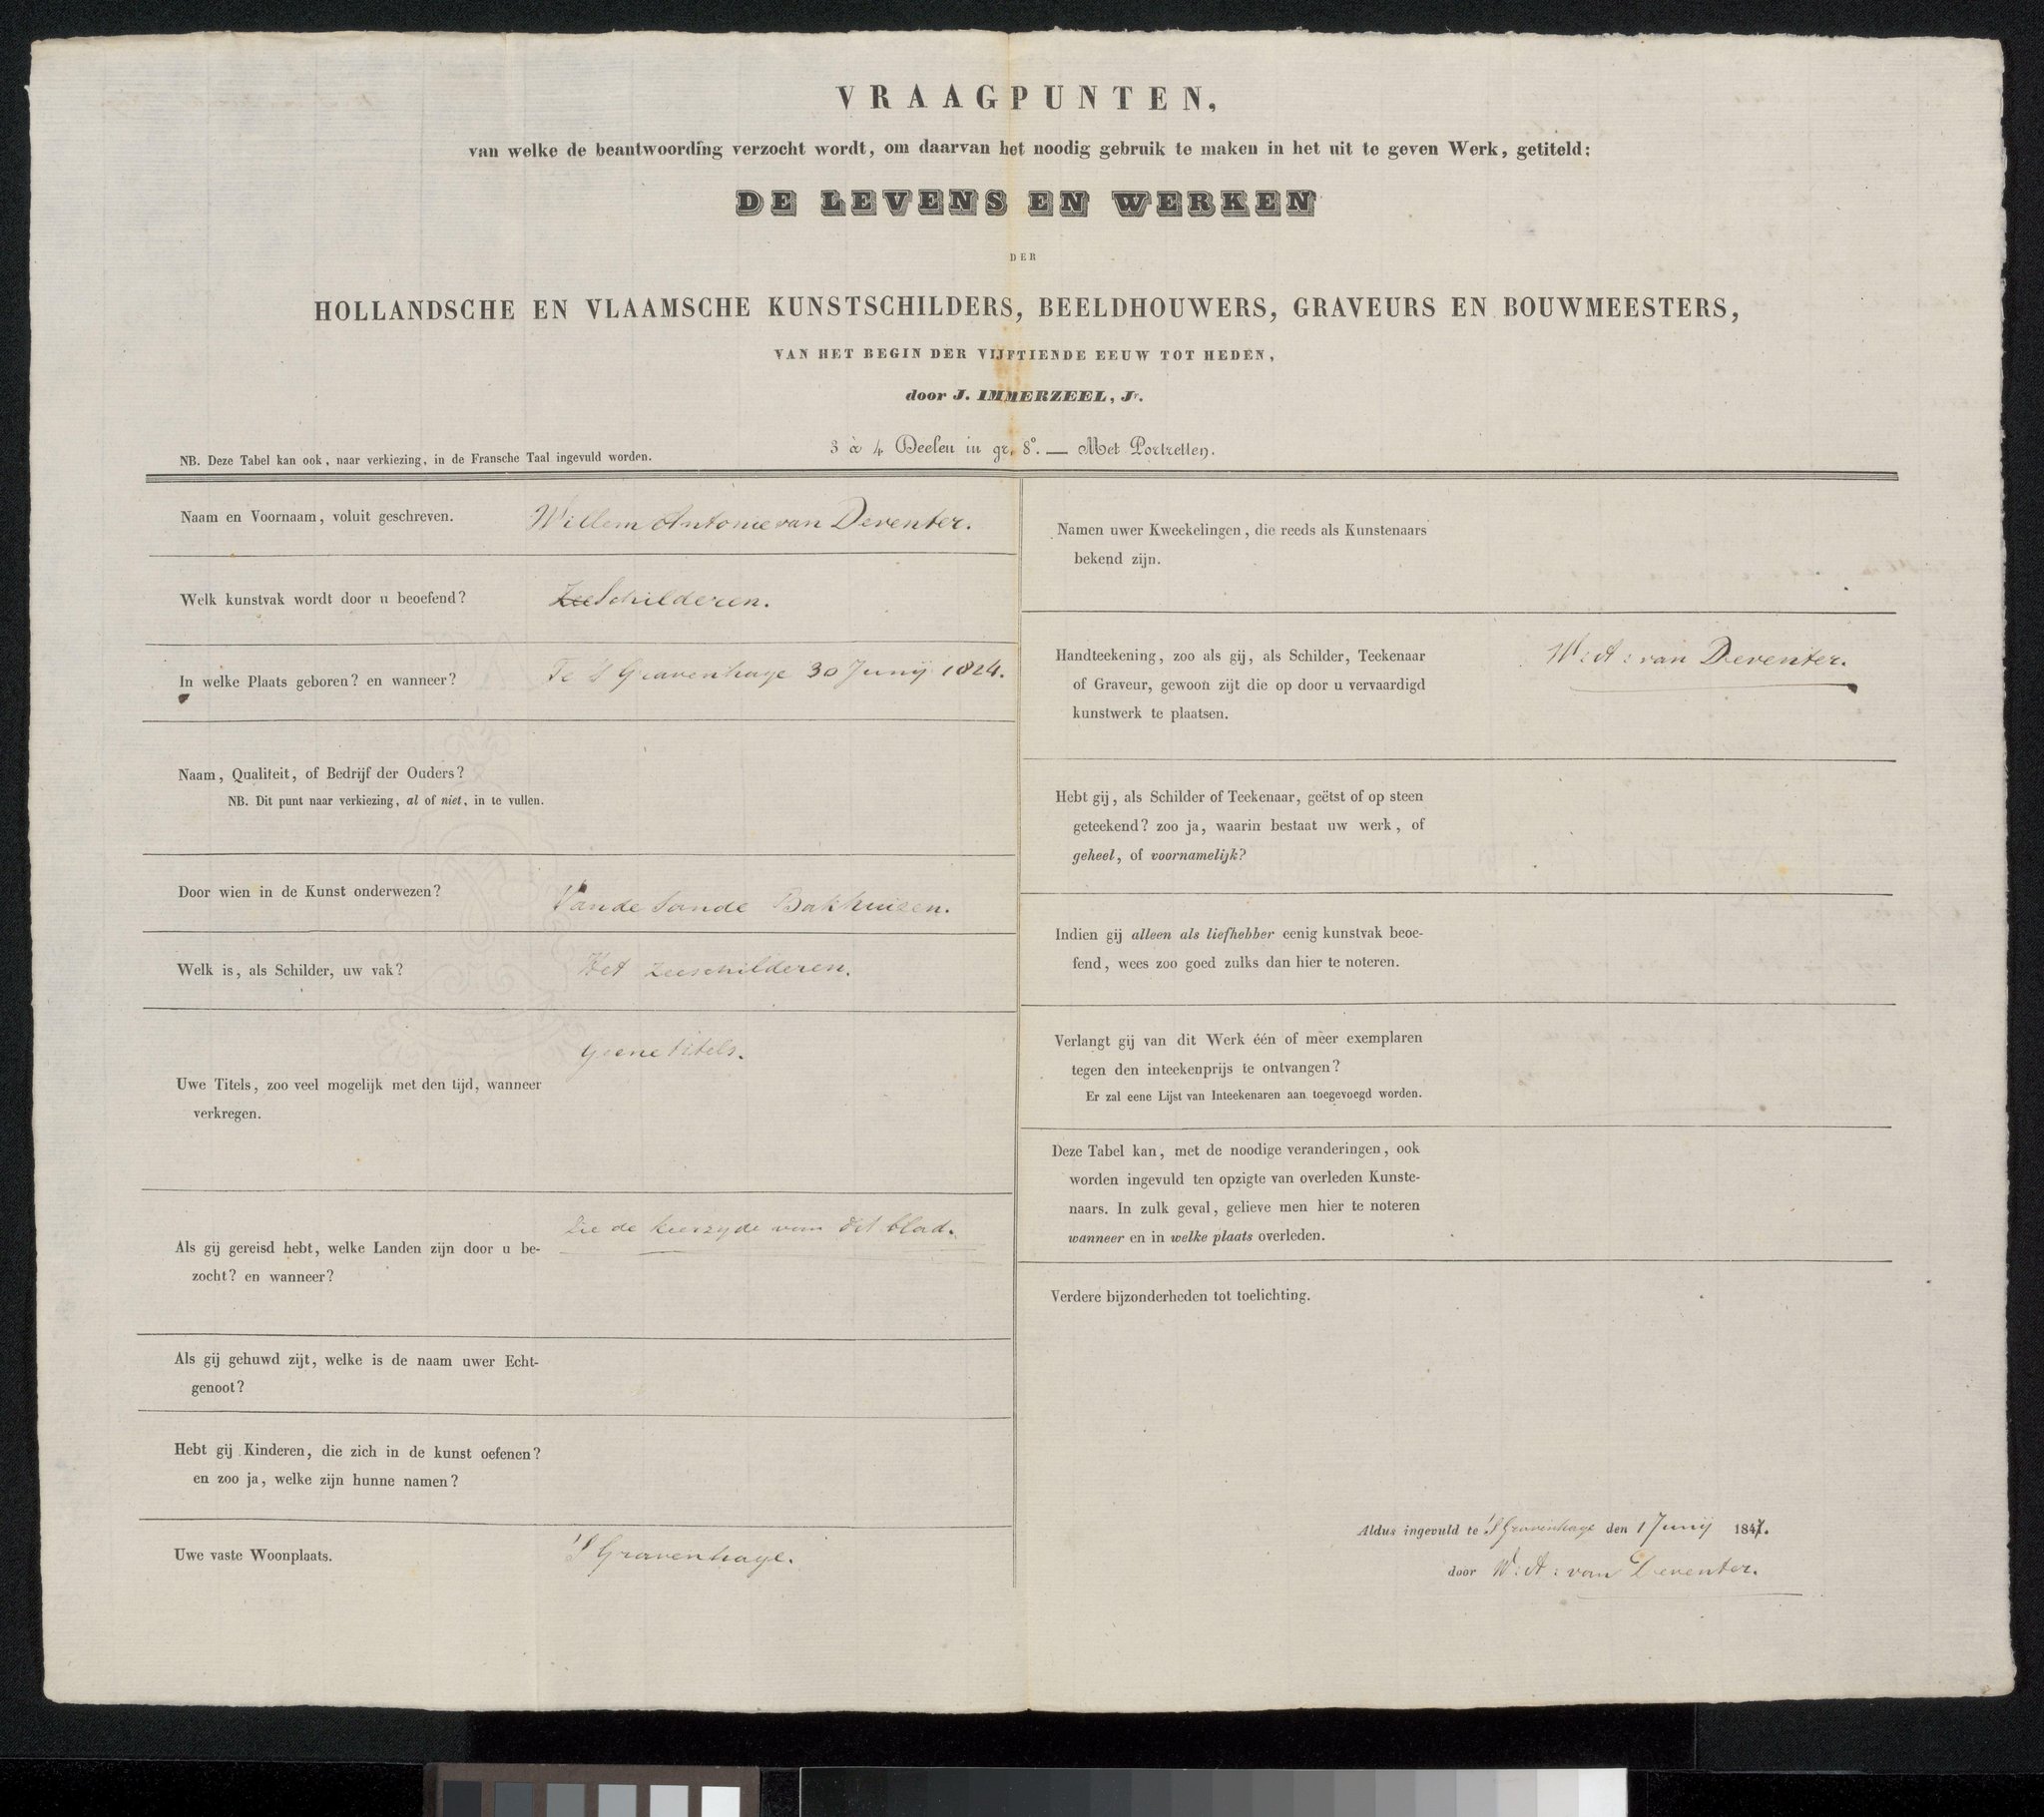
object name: questionnaire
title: Enquêteformulier ingevuld door Willem Anthonie van Deventer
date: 1847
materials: ink, paper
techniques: pen, printing, writing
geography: the hague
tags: painter, print maker, draughtsman, willem anthonie van deventer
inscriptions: watermark, inscription: ‘Vraagpunten,/ van welke de beantwoording verzocht wordt, om daarvan het noodig gebruik te maken in het uit te geven Werk, getiteld: De levens en werken/ der Hollandsche en Vlaamsche kunstschilders, beeldhouwers,/ graveurs en bouwmeesters, van het begin der vijftiende eeuw tot heden/ door J. Immerzeel, Jr.’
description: Bedoeld voor: Immerzeel, J. Jr., De levens en werken der Hollandsche en Vlaamsche kunstschilders, beeldhouwers, graveurs en bouwmeesters, van het begin der vijftiende eeuw tot heden, Amsterdam: J.C. van Kesteren, 1842-1843.